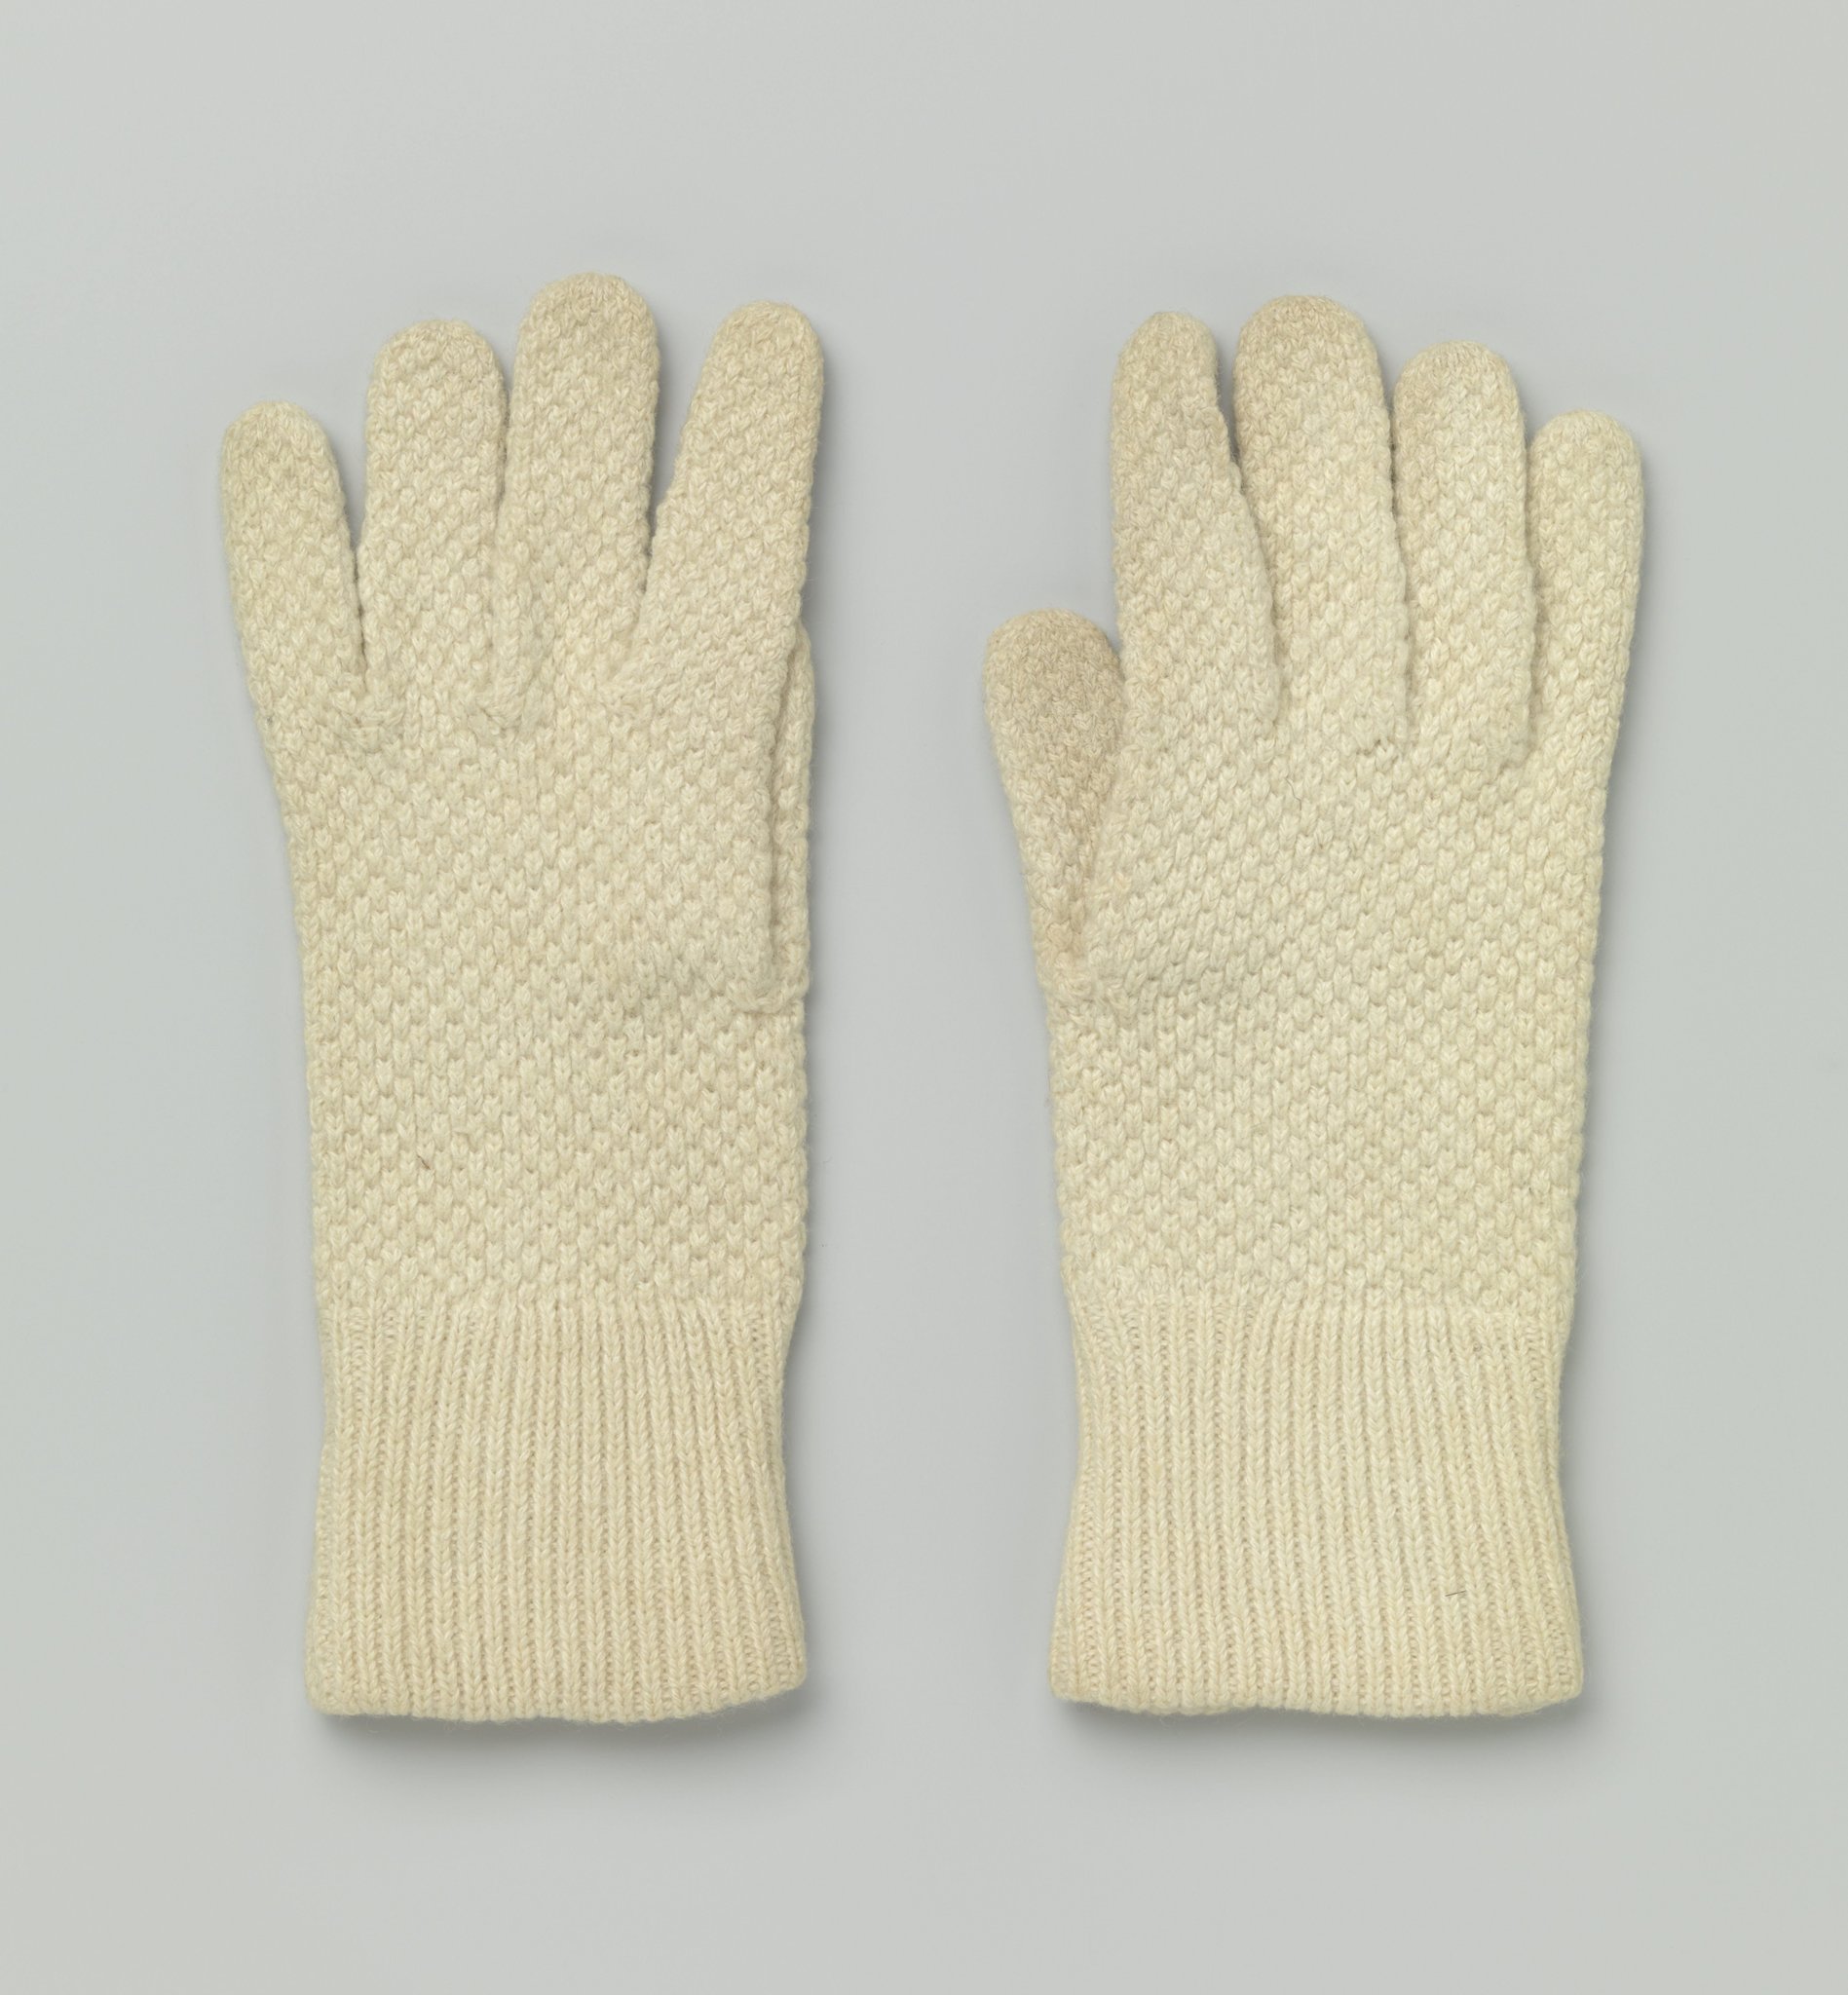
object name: menswear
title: Handschoen van witte wol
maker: Anonymous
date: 1900-1920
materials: wool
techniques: knitting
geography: england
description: Paar heren schaatshandschoenen van witte gebreide wol, z.g. "Ringwood". Model: Kort, met dubbel en gesloten polsboord. Patroon: Gerstenkorrel-Breisel.